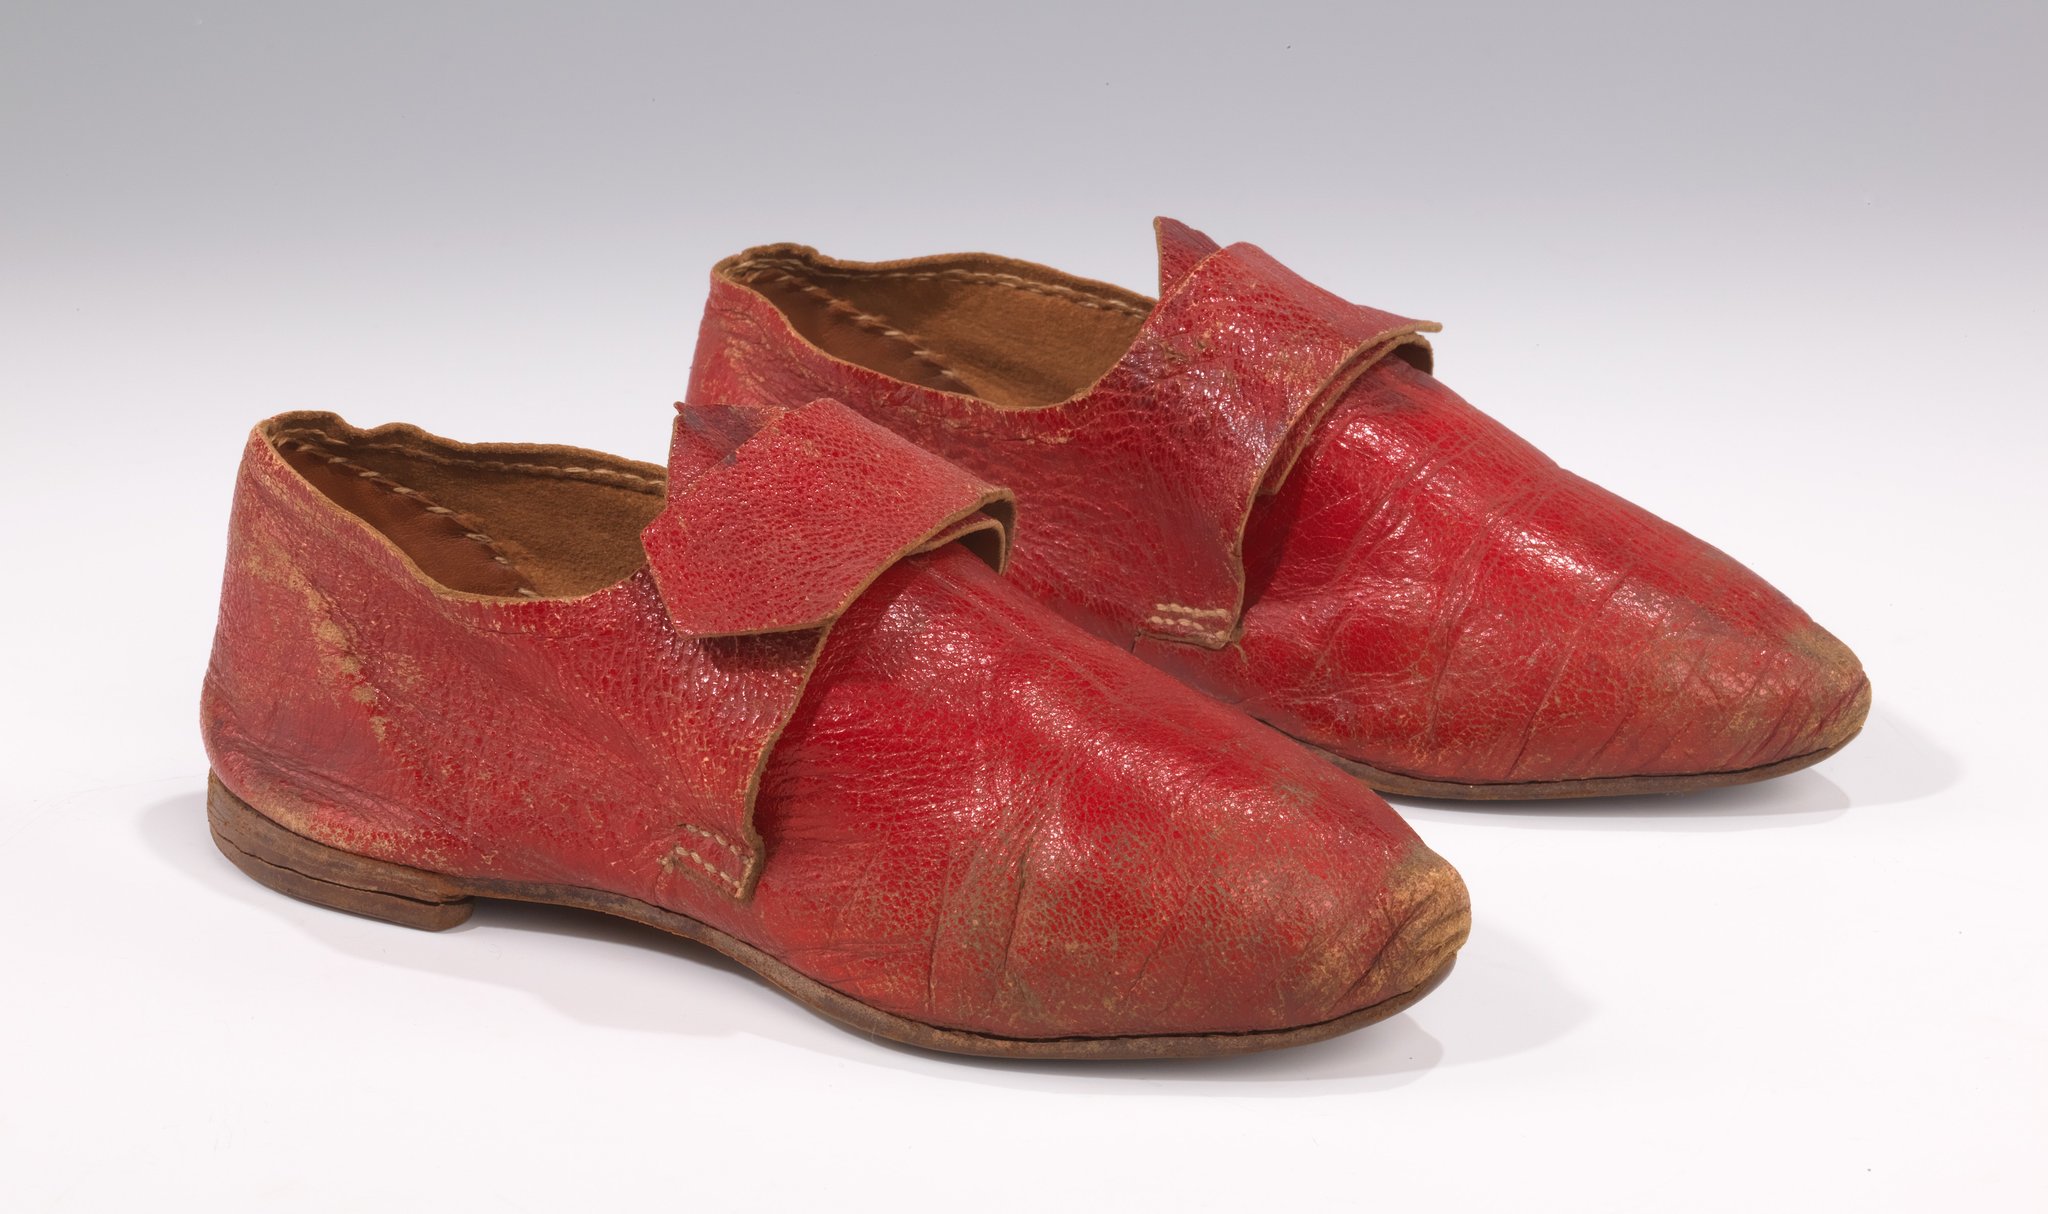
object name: shoe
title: Shoes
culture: european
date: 1767-1800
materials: leather